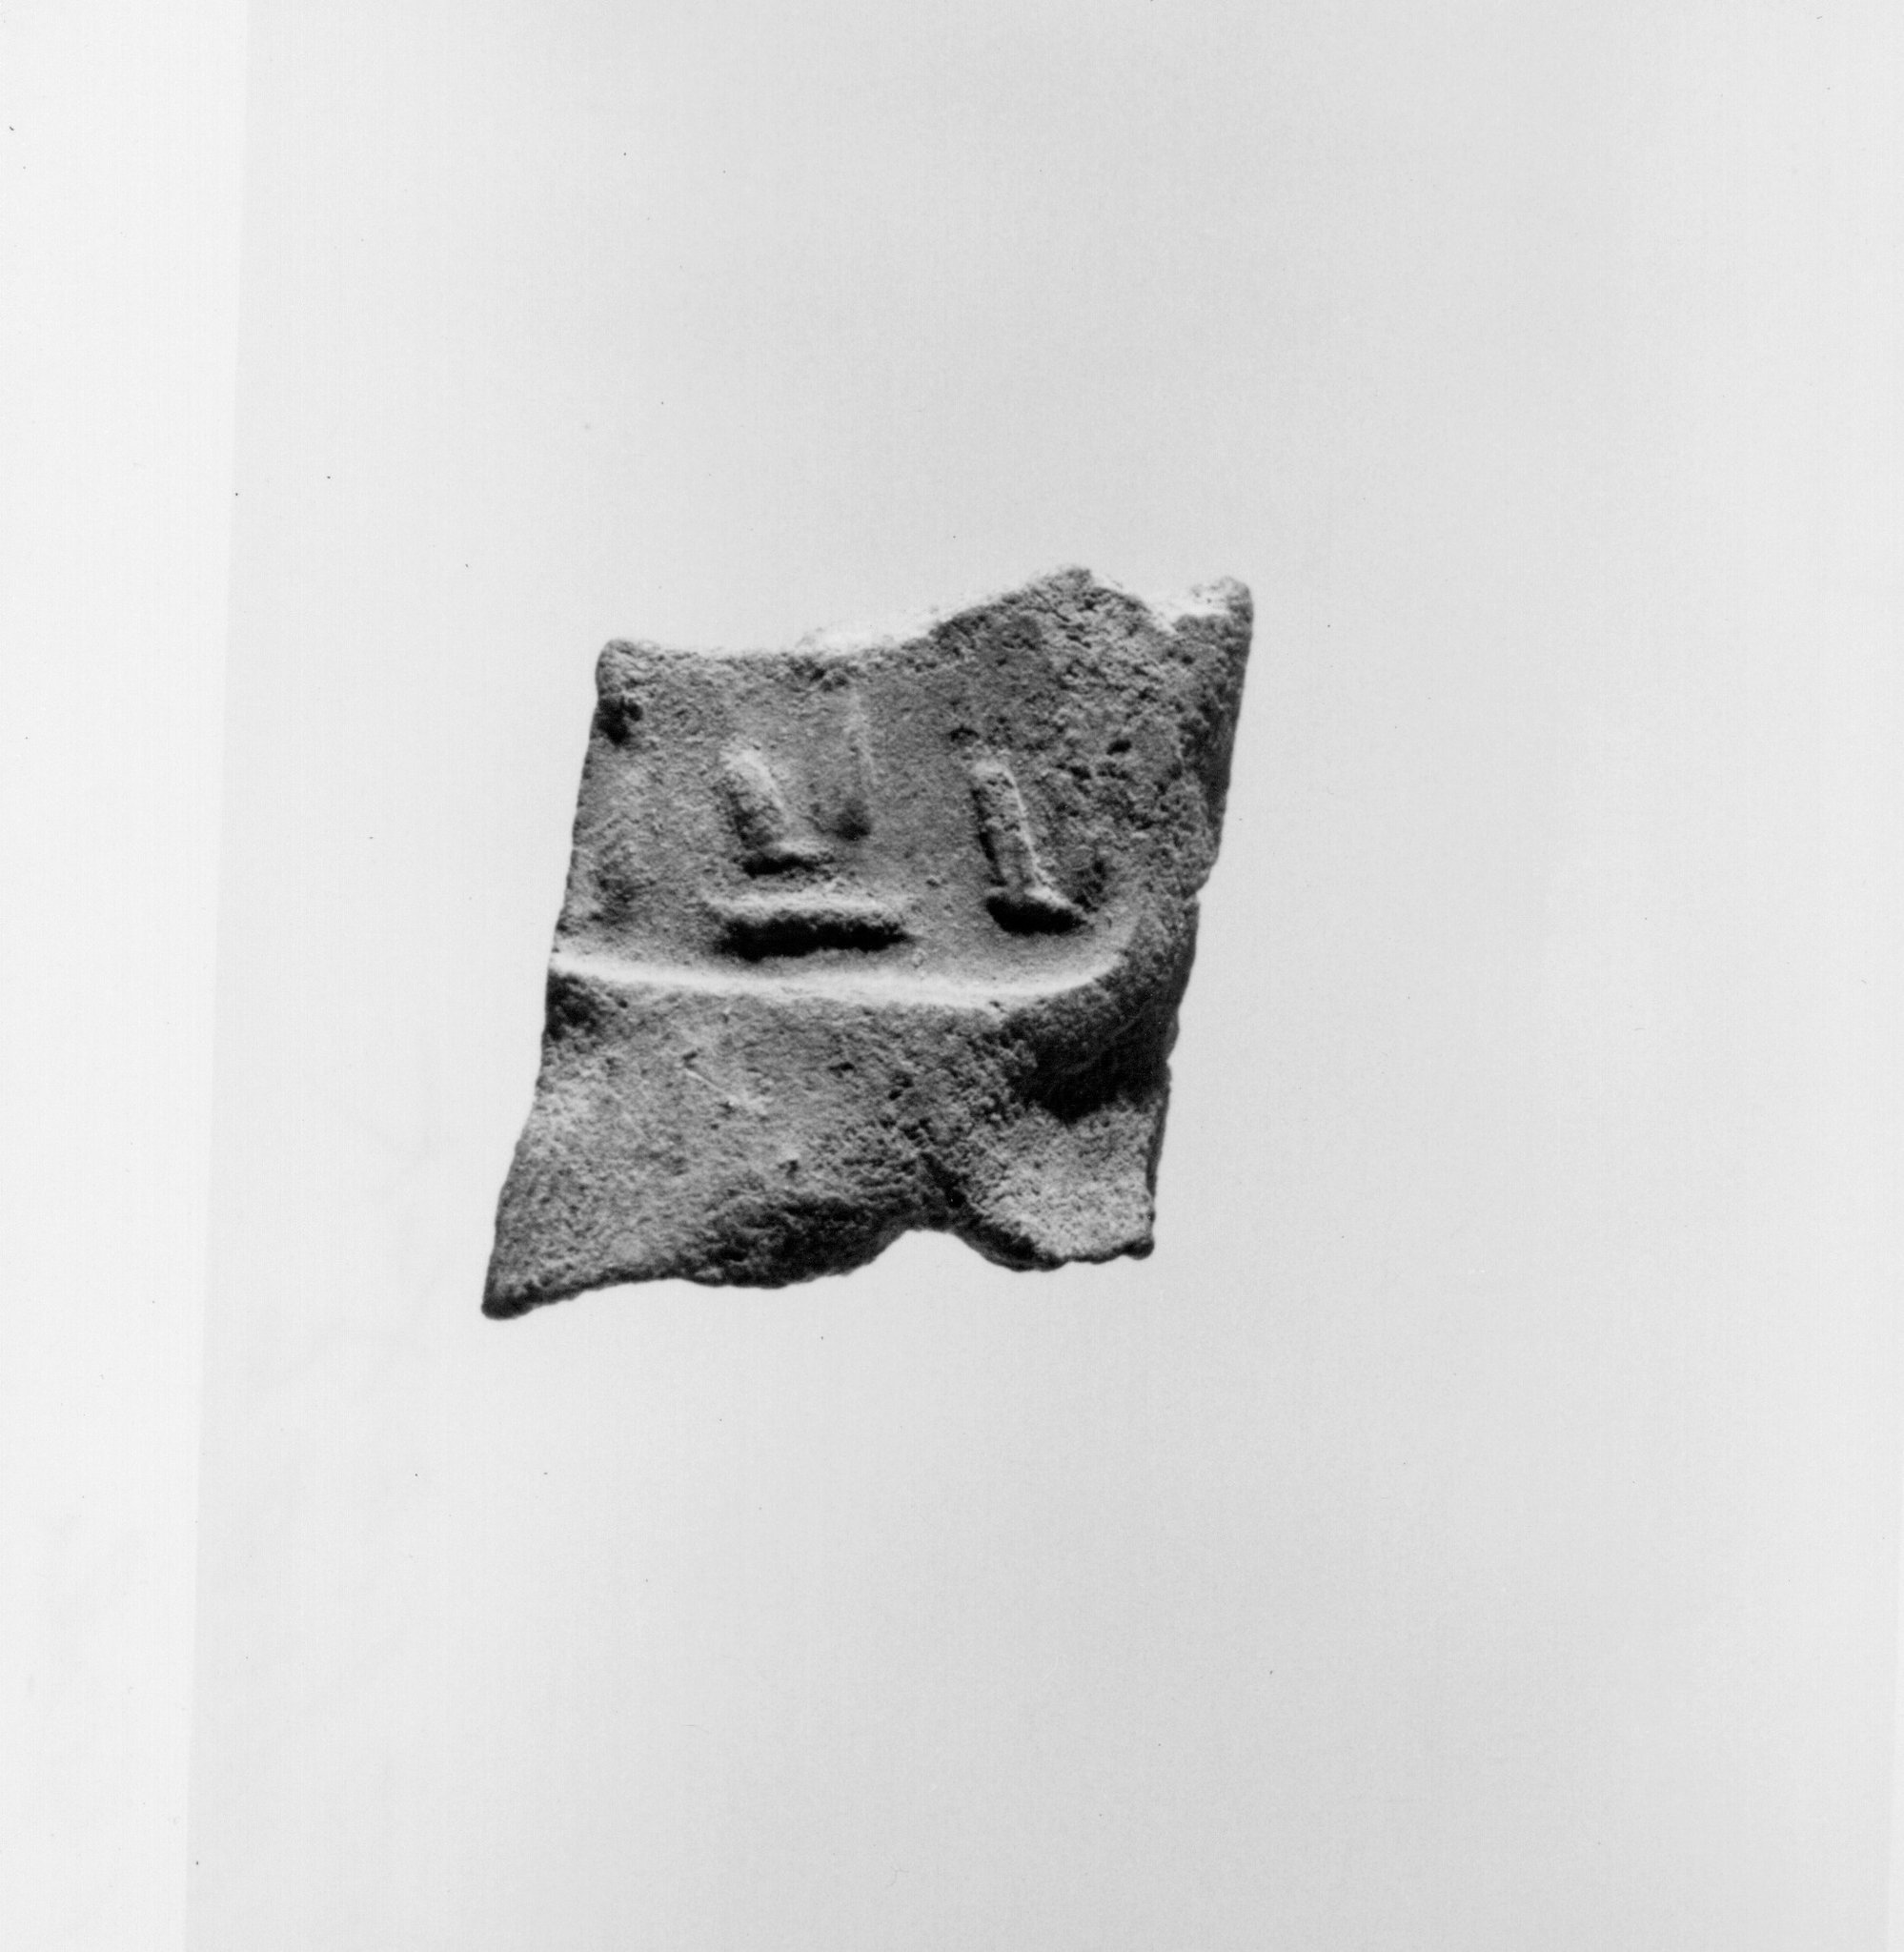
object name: sealing, nebmaatre, amenhotep iii, horus, re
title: Document Sealing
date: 1390-1352 BCE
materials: mud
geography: egypt